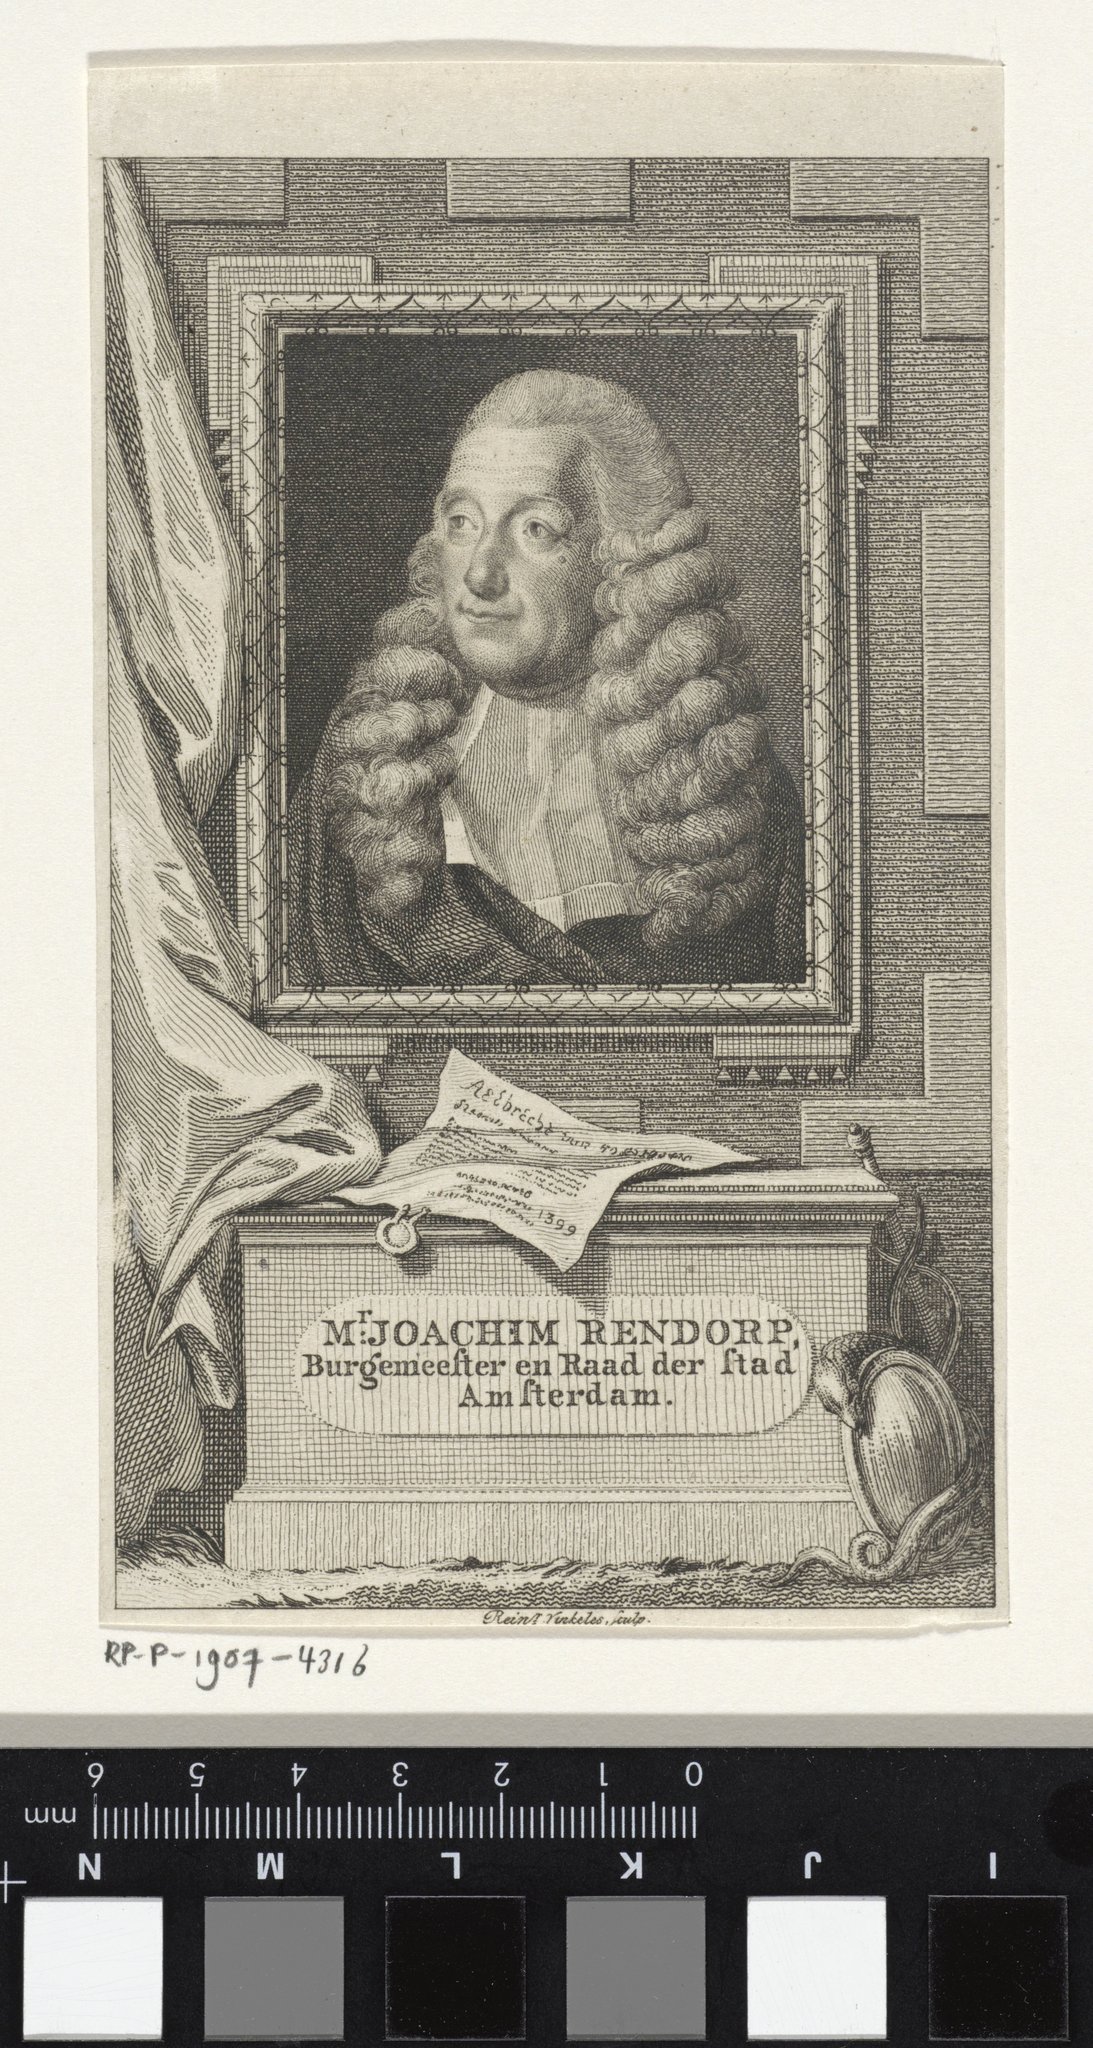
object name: print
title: Portret van Joachim Rendorp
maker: reinier vinkeles (i)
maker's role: draughtsman, print maker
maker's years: 1741-1816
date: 1786-1809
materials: paper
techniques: engraving, etching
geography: amsterdam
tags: amsterdam, mayor, joachim rendorp, prudentia (prudence) as roman personification (+ attributes), seal, stamp, paper (writing material)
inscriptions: collector's mark: Lugt 2228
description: Prent ook gebruikt als boekillustratie in: Wagenaar, Jan. Vaderlandsche historie, (...) ten vervolge van Wagenaars Vaderlandsche historie. Dl. 1-43. Amsterdam: Johannes Allart, 1786-1809.